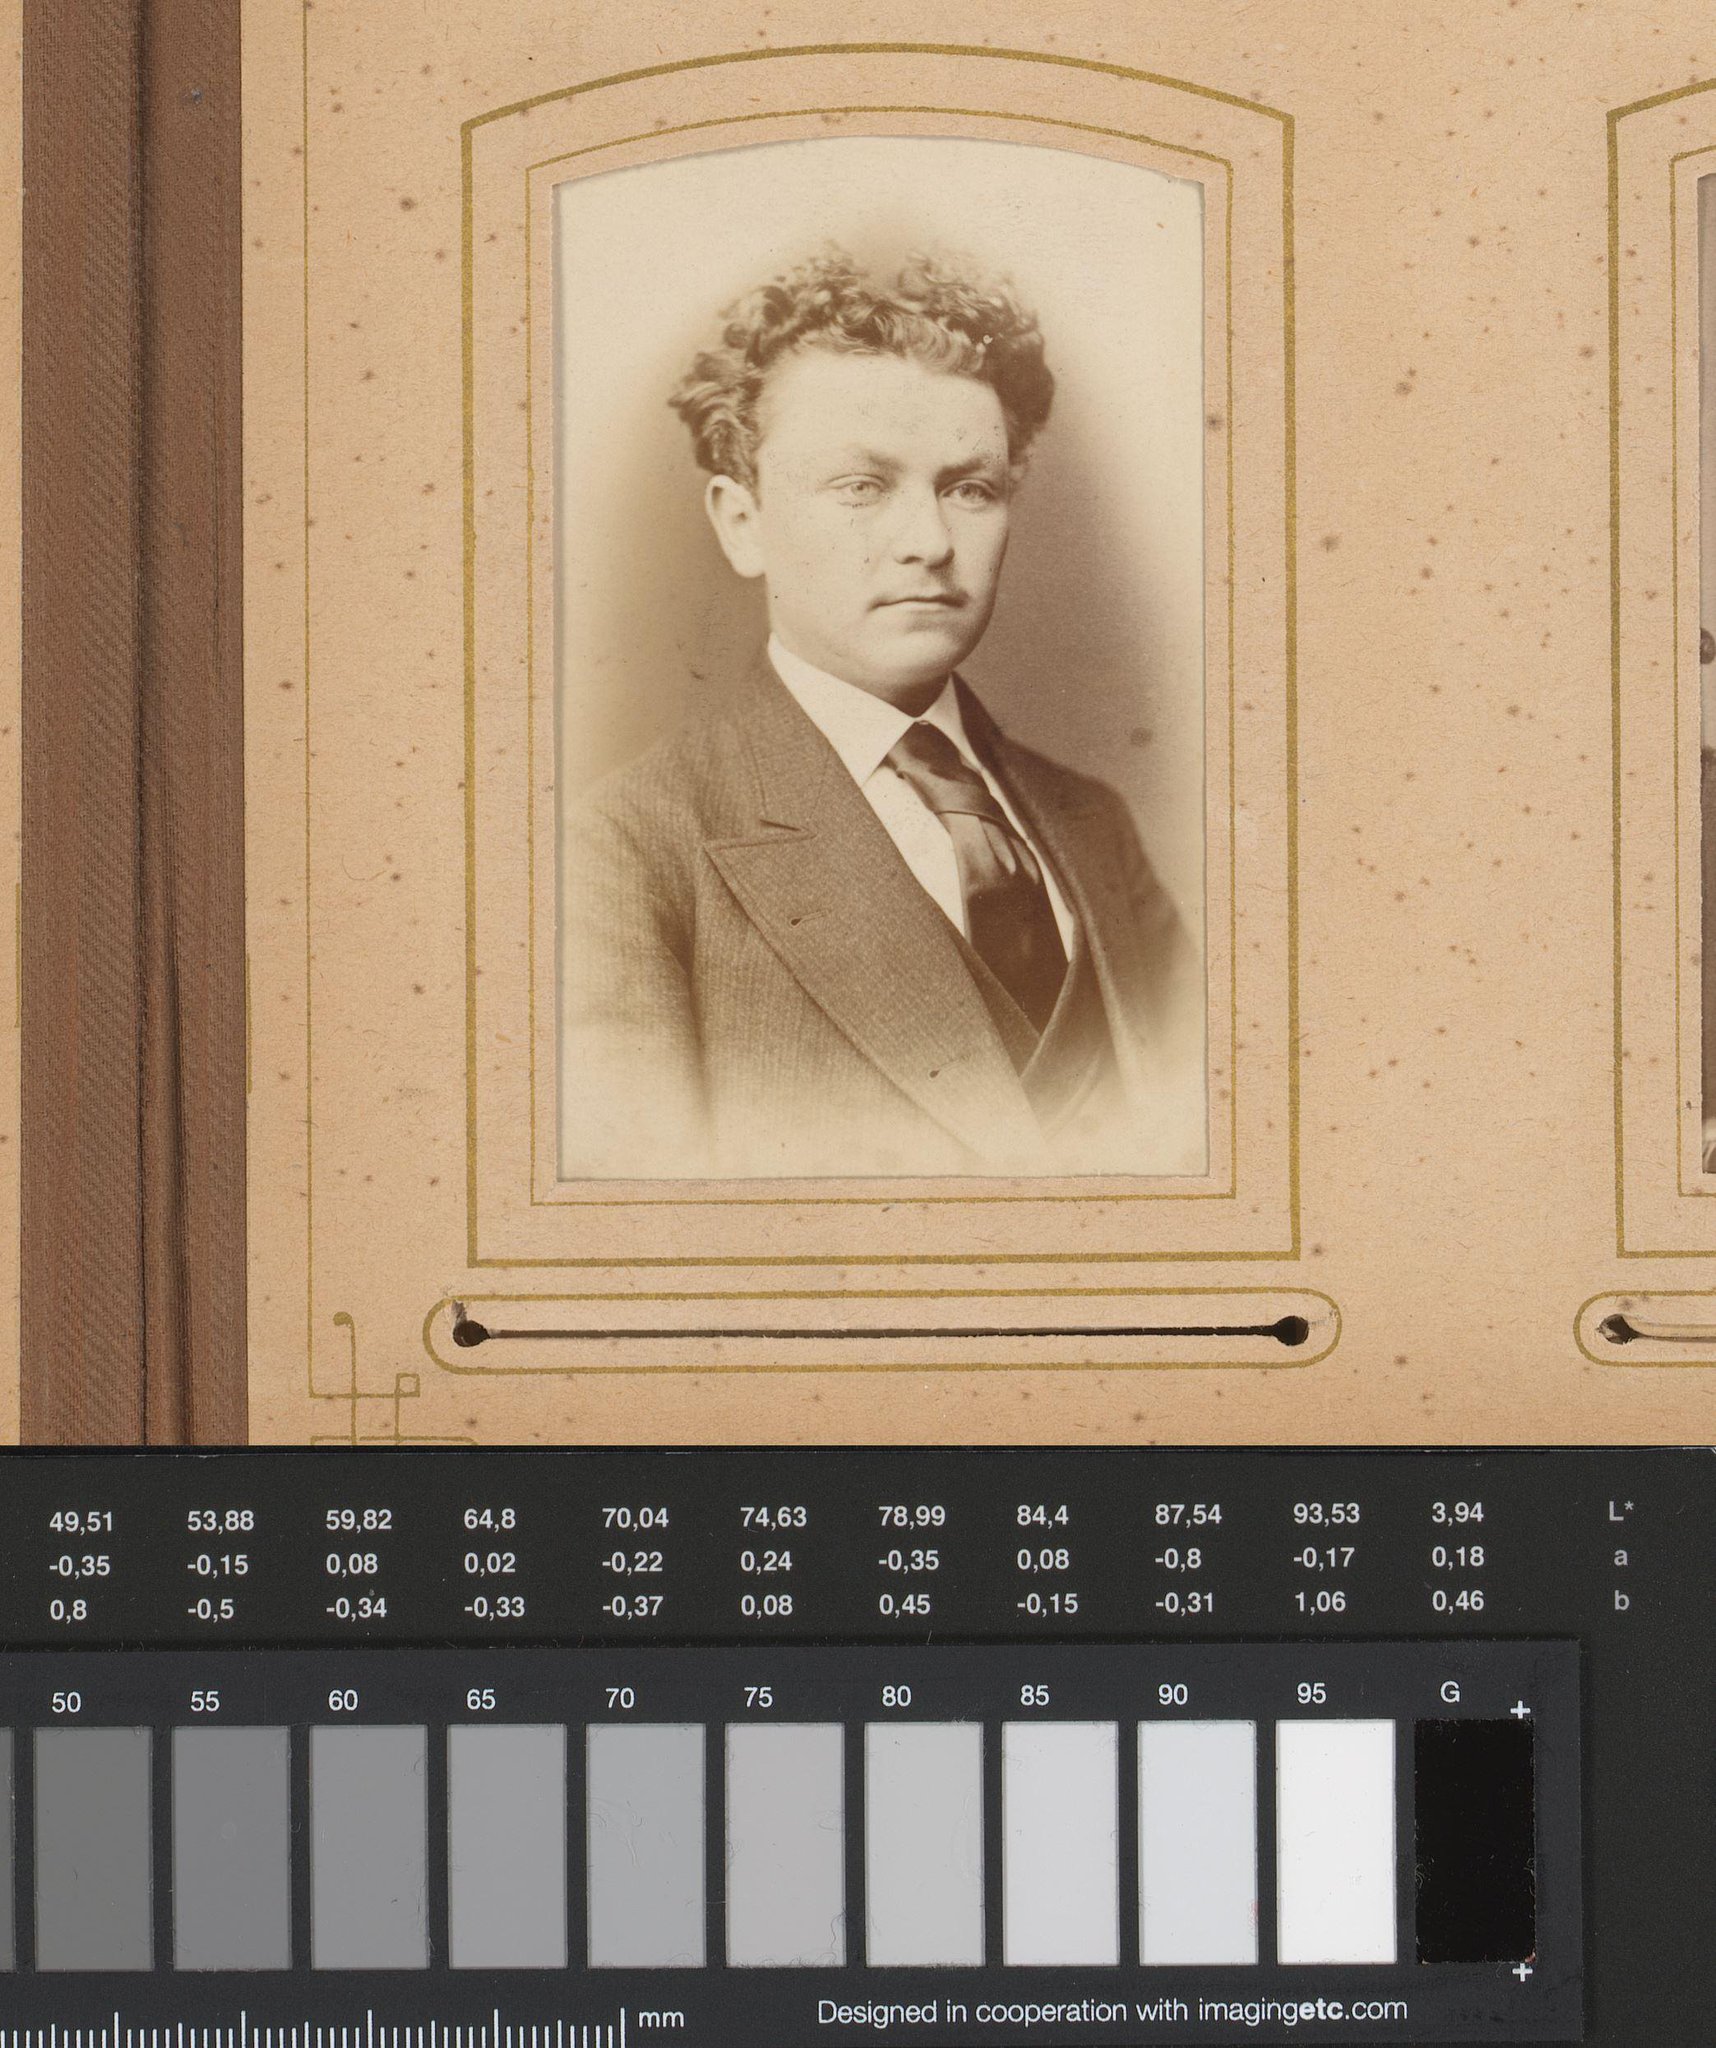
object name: photograph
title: Portret van een jonge man met stropdas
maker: b. obrist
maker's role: fotograaf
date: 1860-1900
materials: cardboard, photographic support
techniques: albumen print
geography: frankenthal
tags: historical persons, youth, adolescent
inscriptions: inscription: ‘Photographie/ von/ B. Obrist/ vis-à-vis dem Bahnhofe/ FRANKENTHAL./ Von diesem Bilde kann stets nachbestellt werden.’